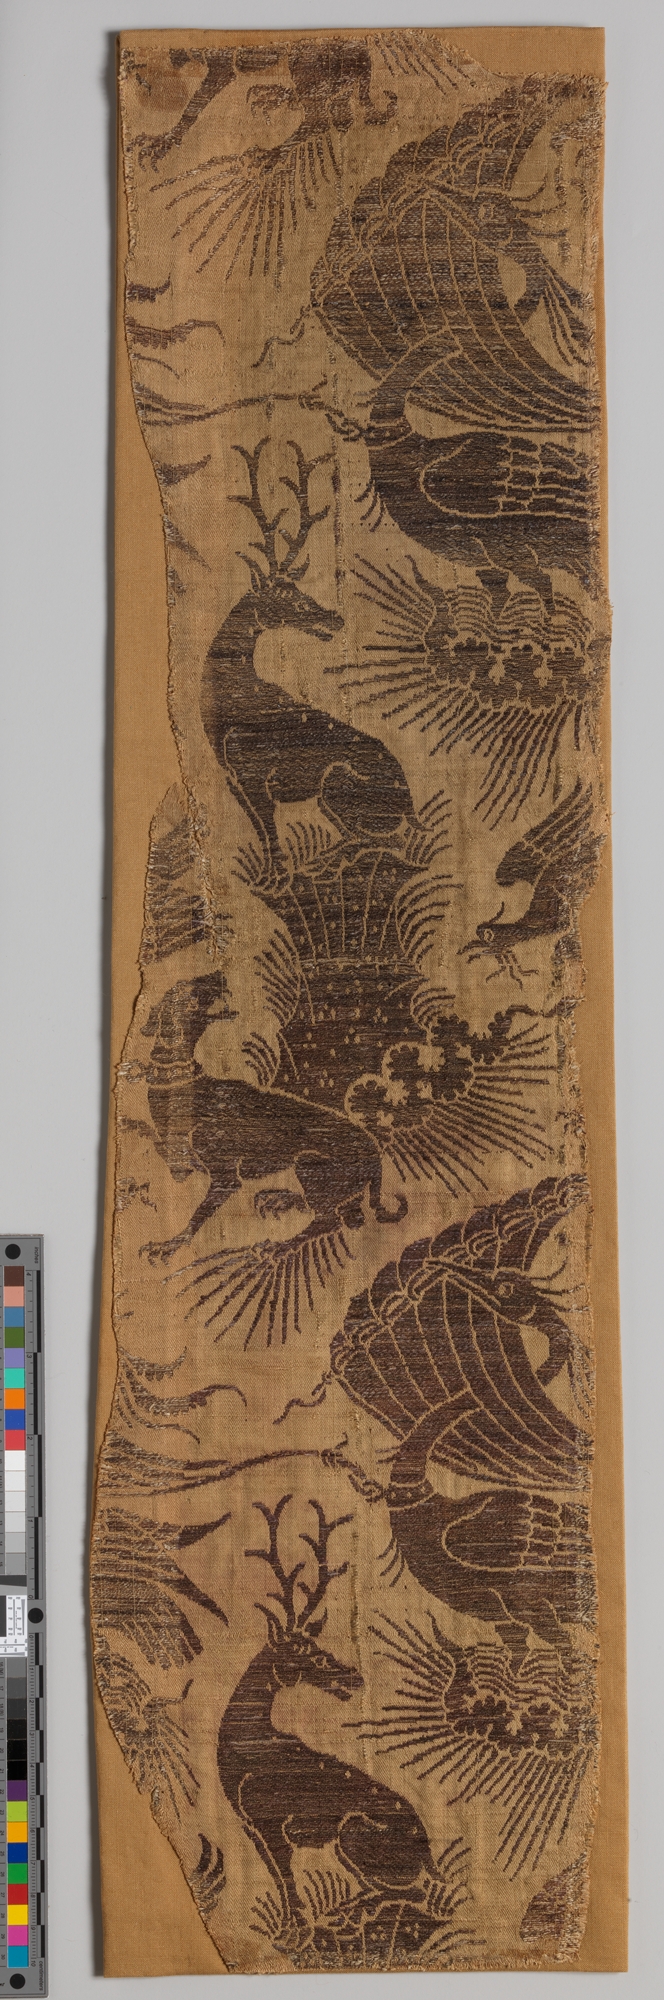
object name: textile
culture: italian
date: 1301-1400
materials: metal thread, silk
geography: italy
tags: peacocks,deer,dogs